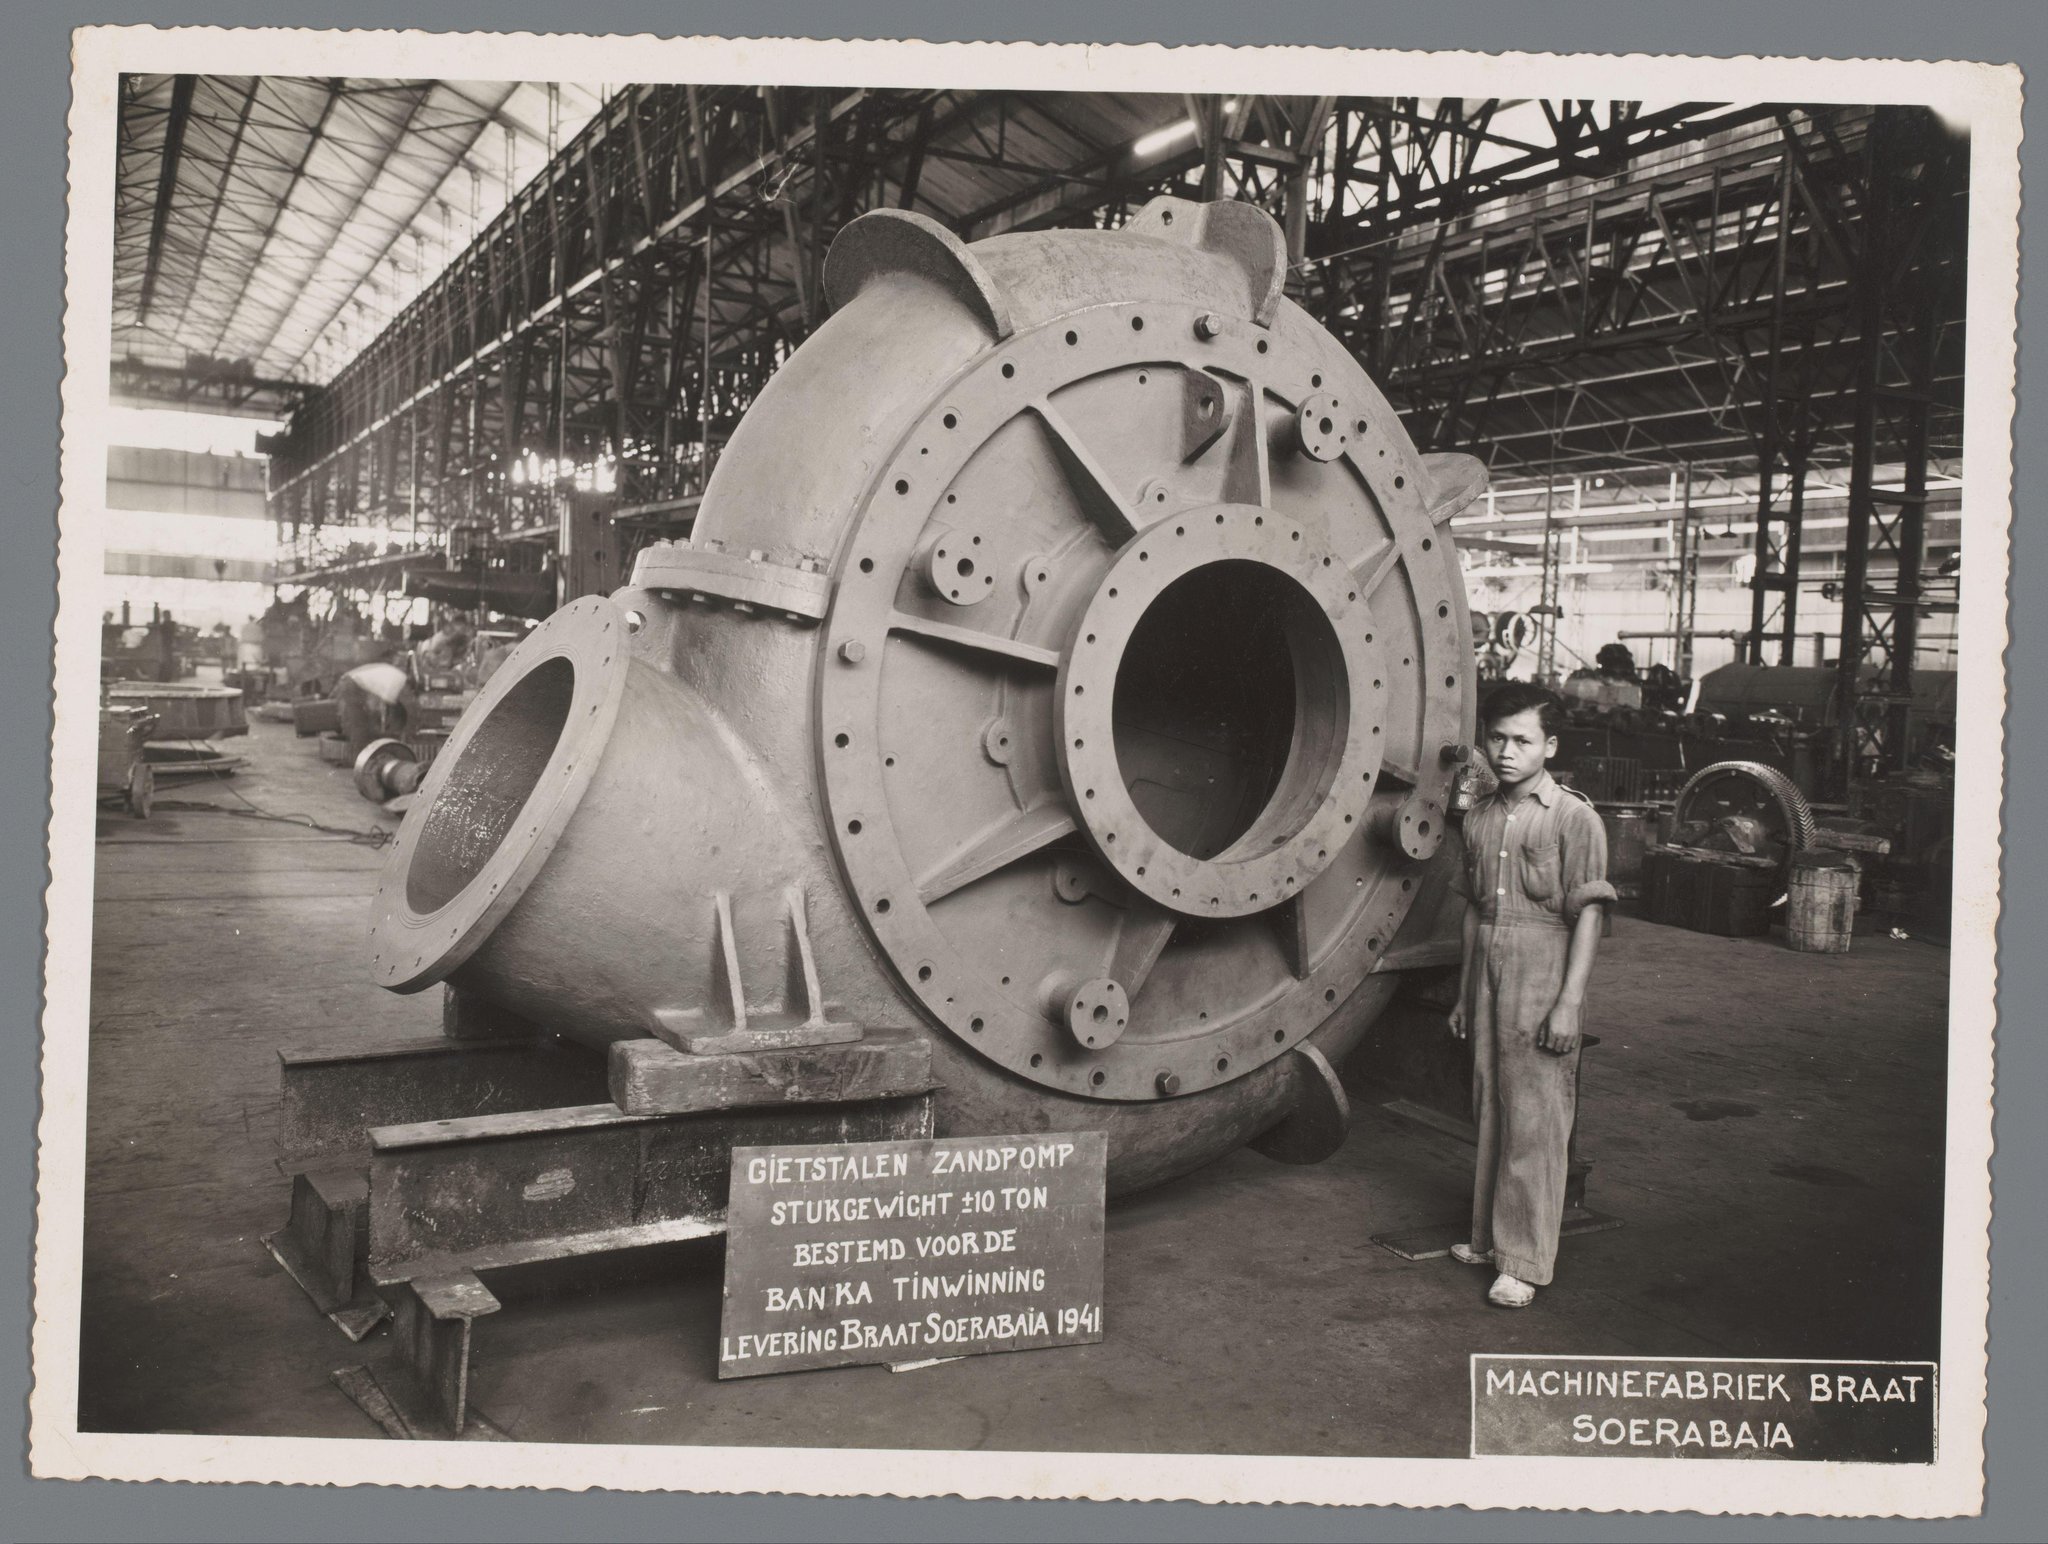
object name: photograph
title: Zandpomp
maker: Anonymous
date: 1941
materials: photographic support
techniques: gelatin silver print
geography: surabaya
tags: colonial system, machines; parts of machines; tools and appliances, factory-interior, machine shop (+ men (labourers)), java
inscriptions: date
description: Een gietstalen zandpomp, vervaardigd in 1941 en bestemd voor de Banka Tinwinning. Onderdeel van de multomap met foto's van machines van de N.V. Machinefabriek Braat te Soerabaja, Soekaboemi en Jogyakarta, uit de periode 1908-1942.